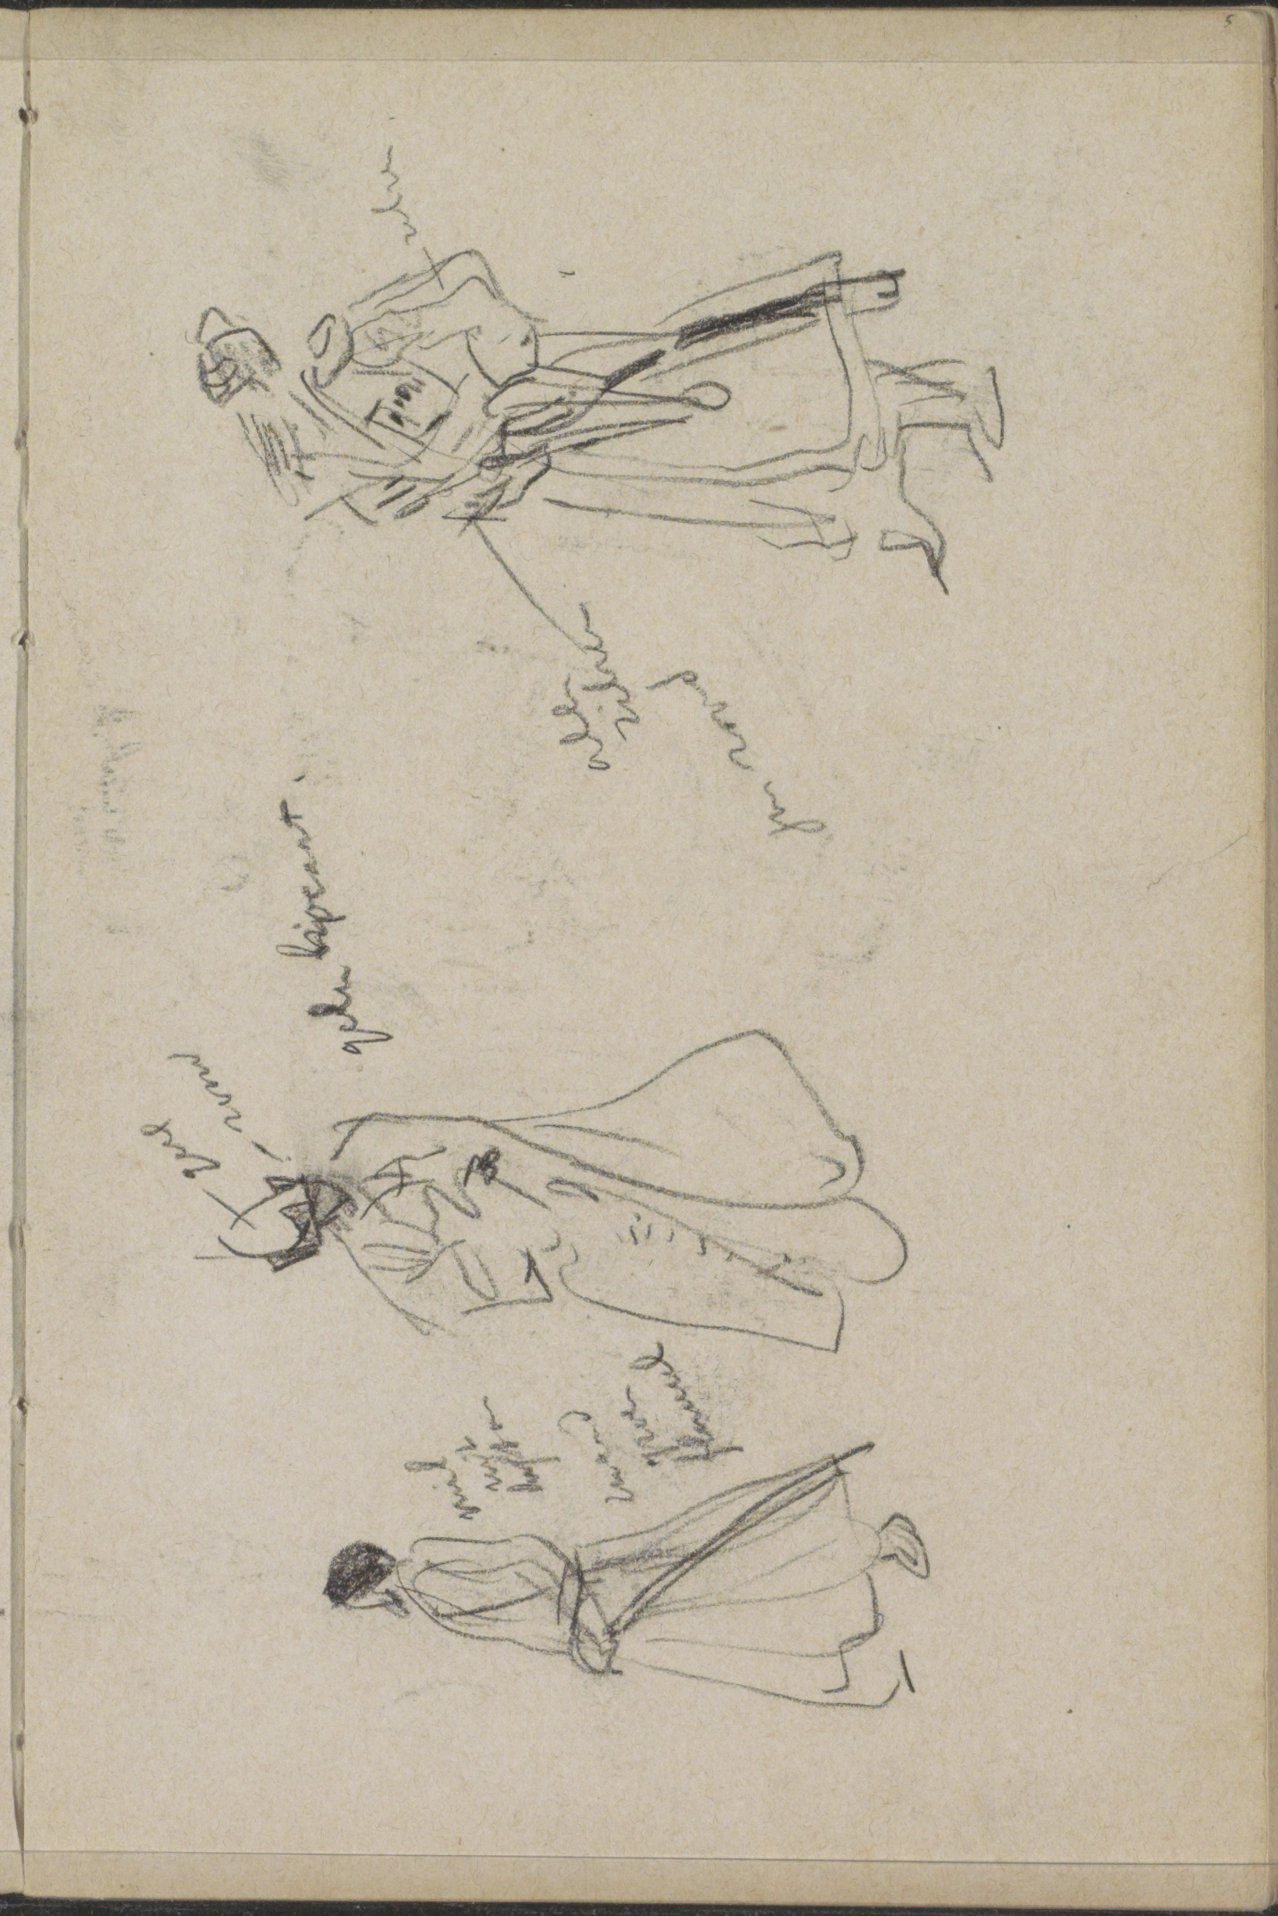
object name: sketchbook leaf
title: Mannen in gewaden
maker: marius bauer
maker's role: draughtsman, print maker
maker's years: 1867-1932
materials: chalk, paper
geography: moscow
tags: standing figure, adult man, folk costume, regional costume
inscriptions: kleurnotitie, handgeschreven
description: De figuren dragen verschillende gewaden, waaronder één rijk gedecoreerd gewaad. Mogelijk gaat het om hoogwaardigheidsbekleders die aanwezig waren bij de kroning van tsaar Nicolaas II. Pagina 5 uit een schetsboek met 54 bladen.